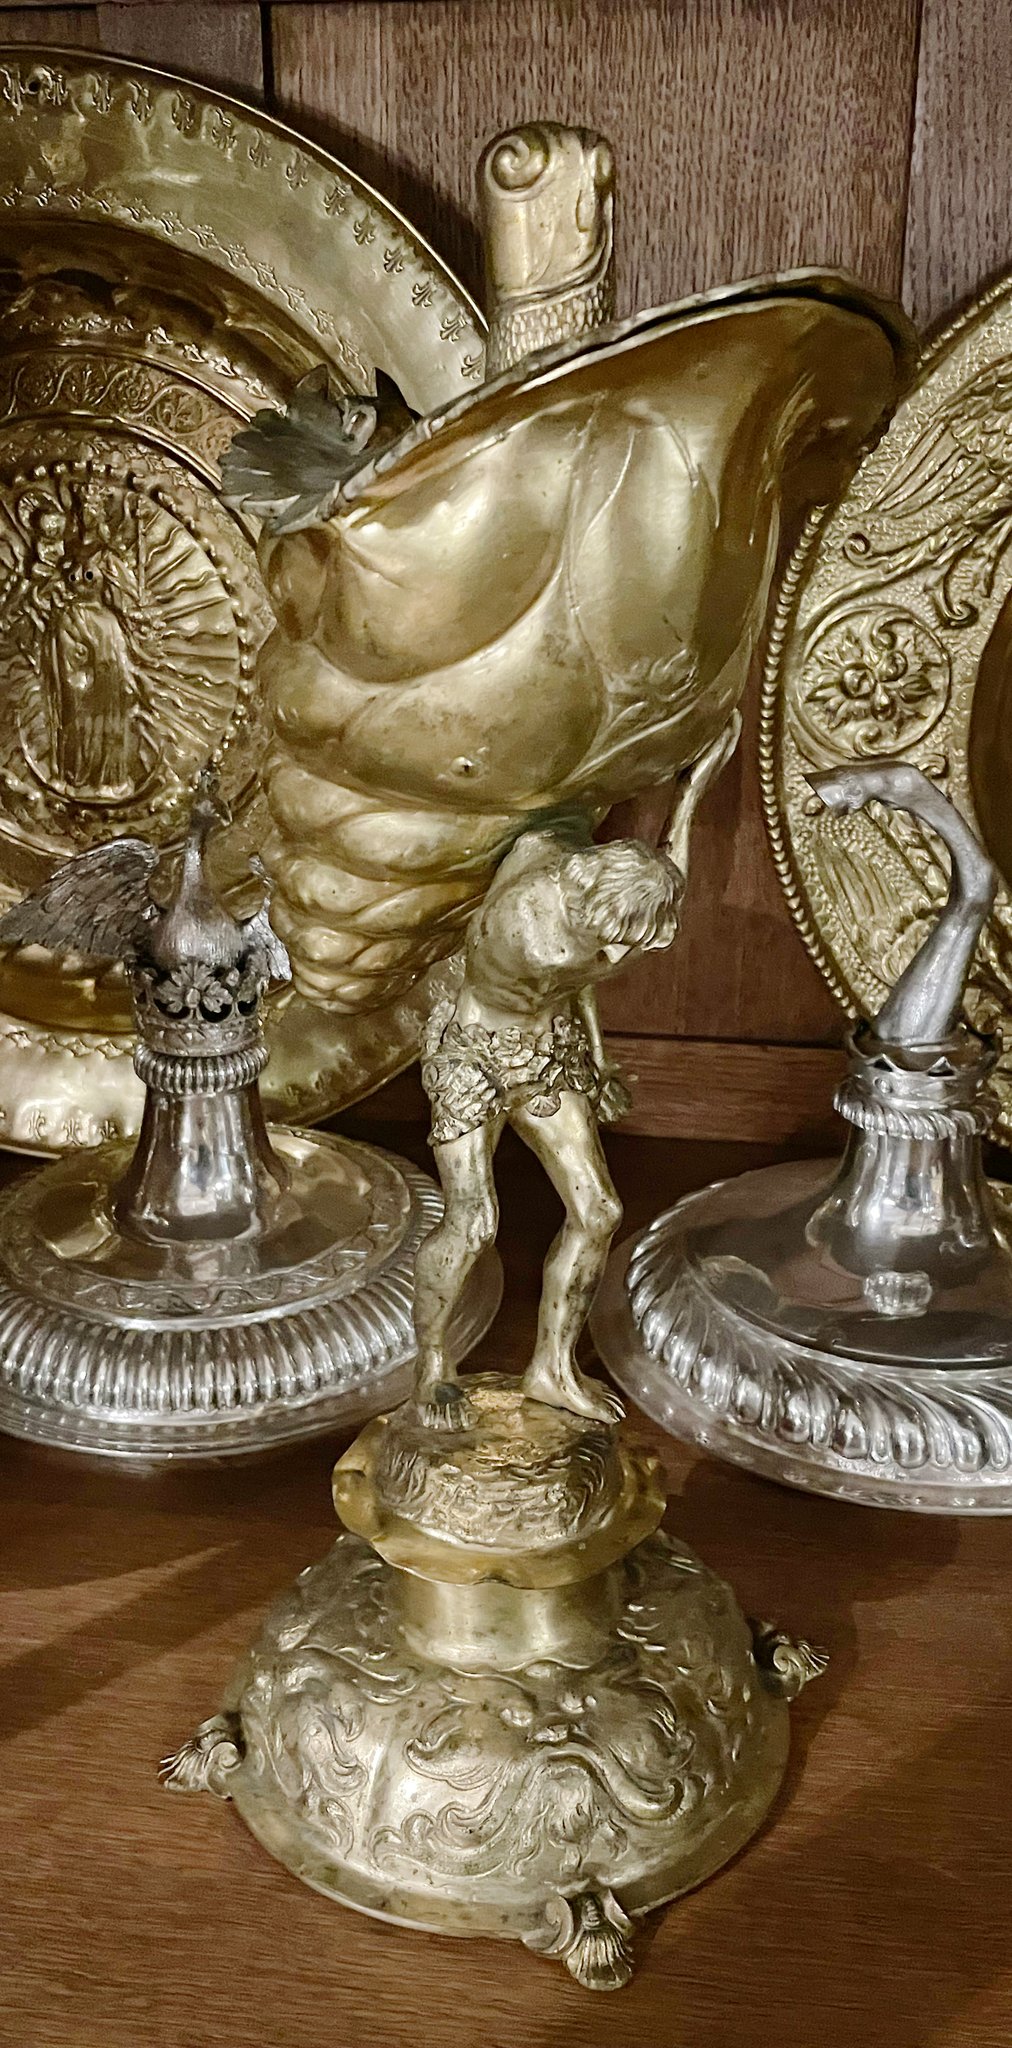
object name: cup with cover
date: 1801-1900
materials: metal, silver